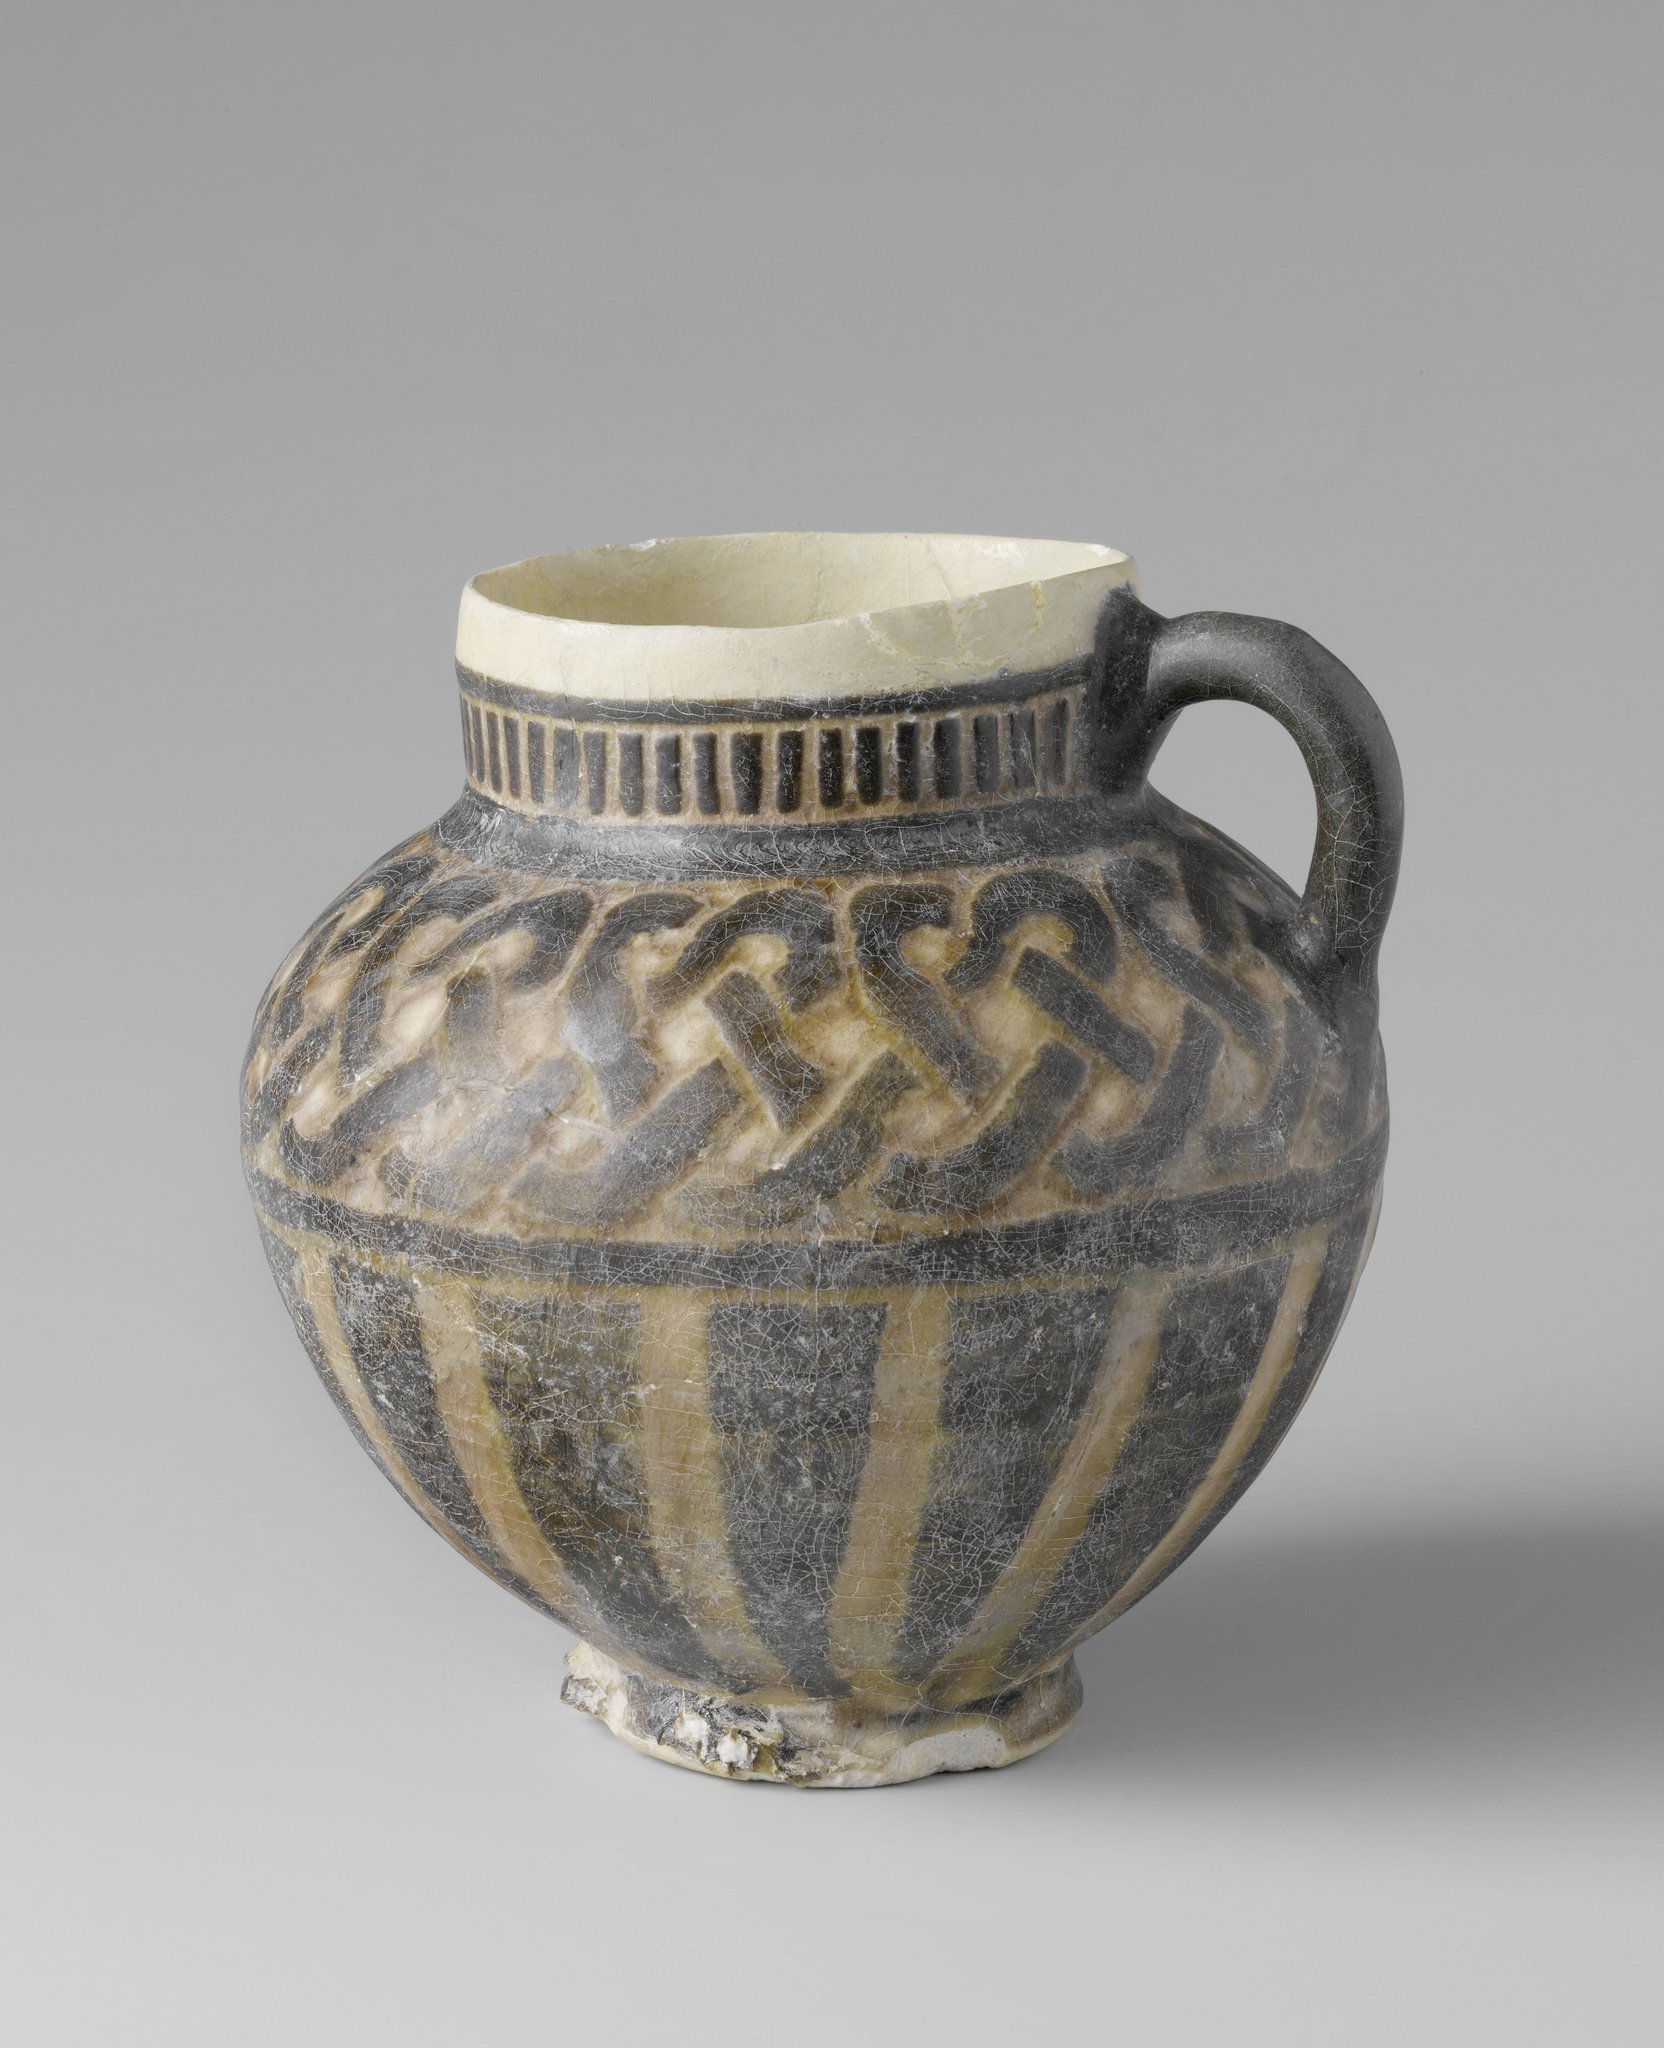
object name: ewer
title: Ovoid jar with a wicker decoration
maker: Anonymous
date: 1175-1199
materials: earthenware, glaze, quartz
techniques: enamel, cutting, firing, turning, vitrification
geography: iran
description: Kan van kwarts-fritgoed gedecoreerd met vlechtwerk en strepen weggesneden uit engobe van zwarte slib onder een transparante alkaliglazuur.